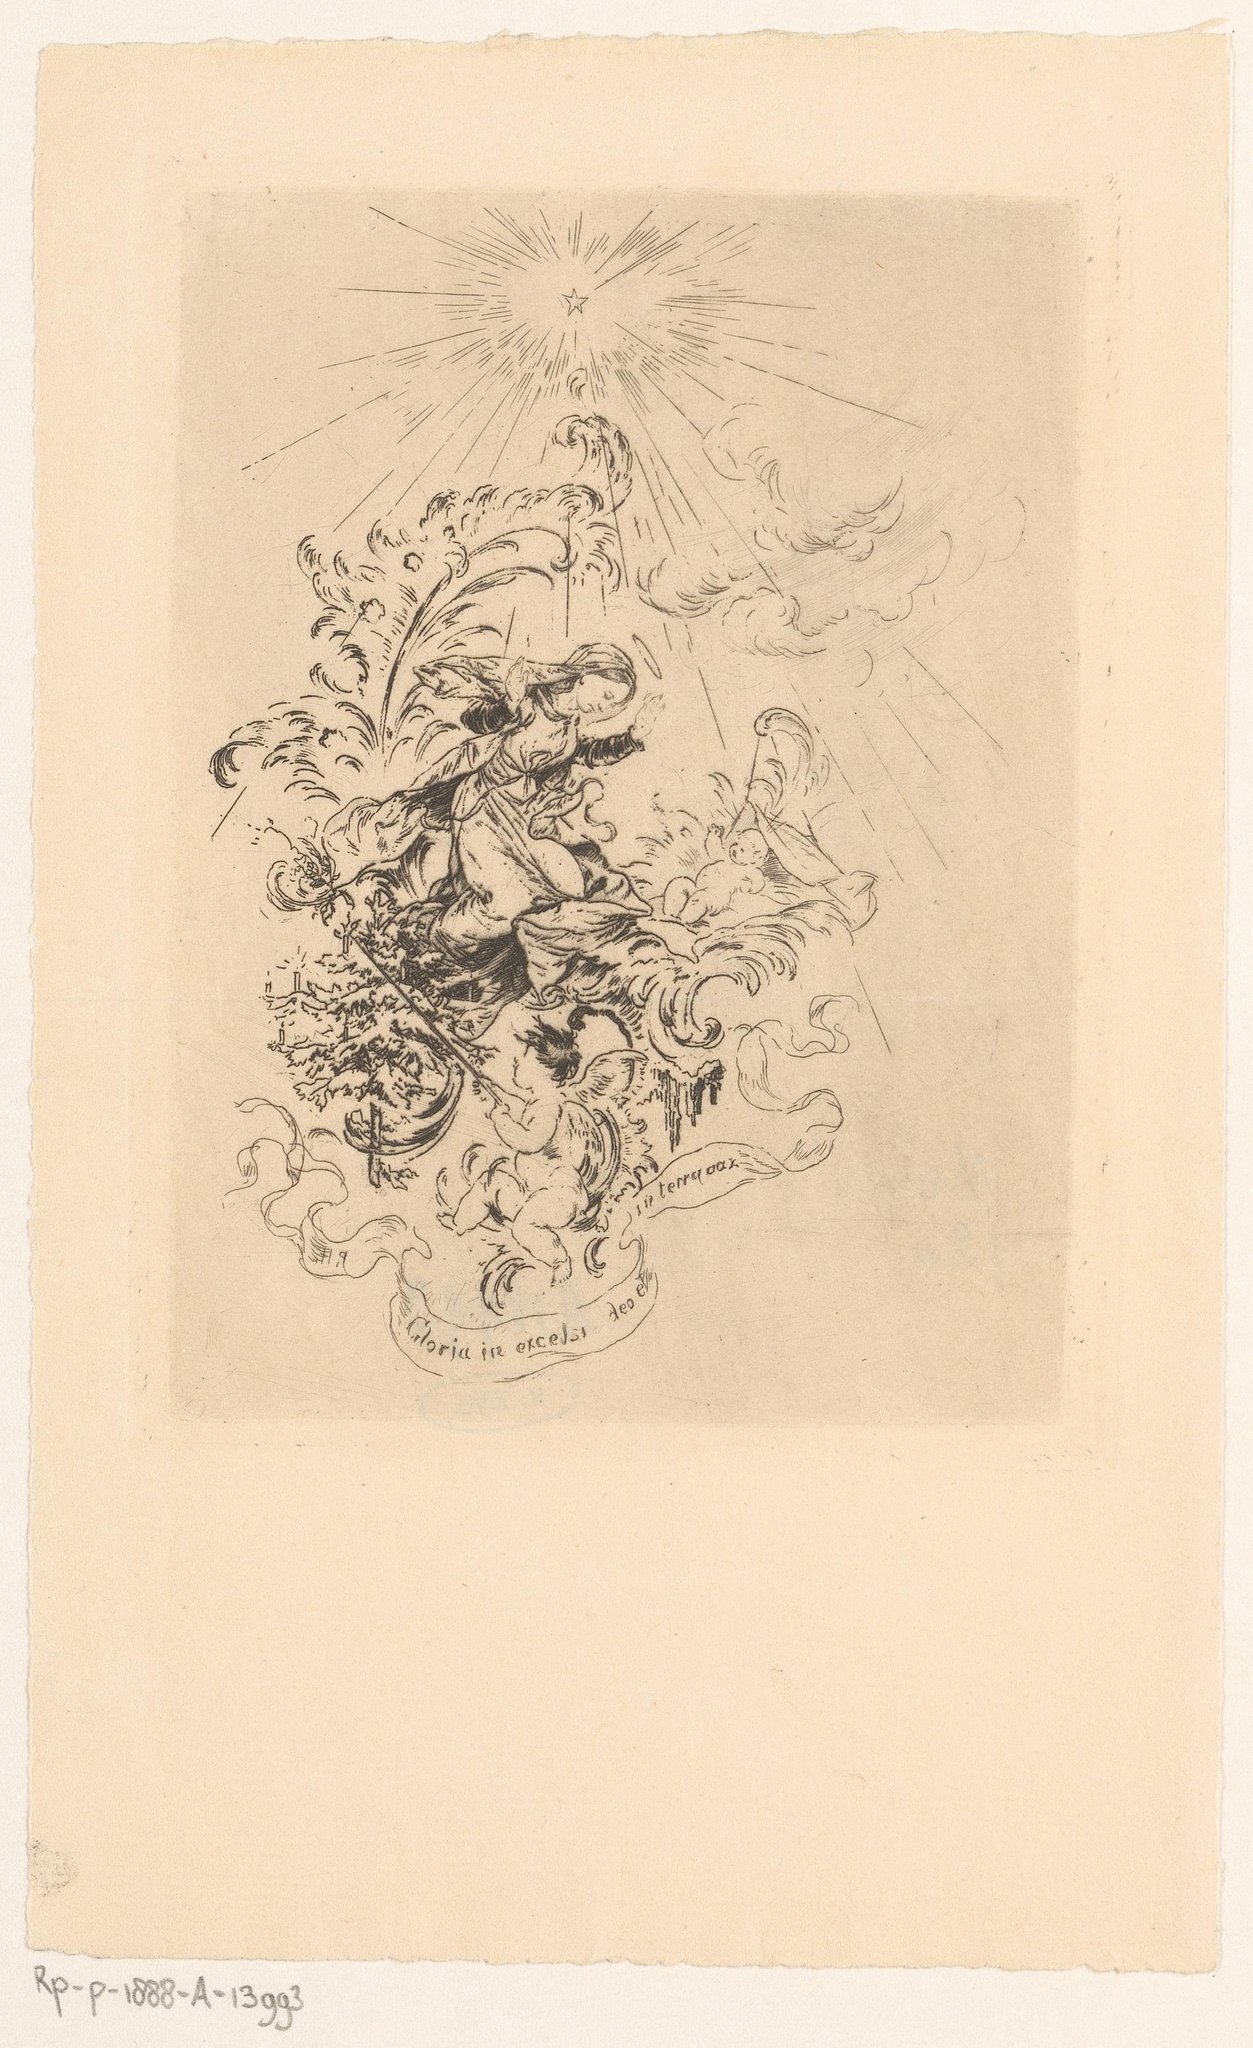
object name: print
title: Allegorie op de kerstnacht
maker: peter von halm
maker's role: print maker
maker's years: 1854-1923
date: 1864-1888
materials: paper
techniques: etching, intaglio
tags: christmas tree, story of the birth of christ (luke 2:1-20), stars, represented symbolically or allegorically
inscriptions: collector's mark: Lugt 2228